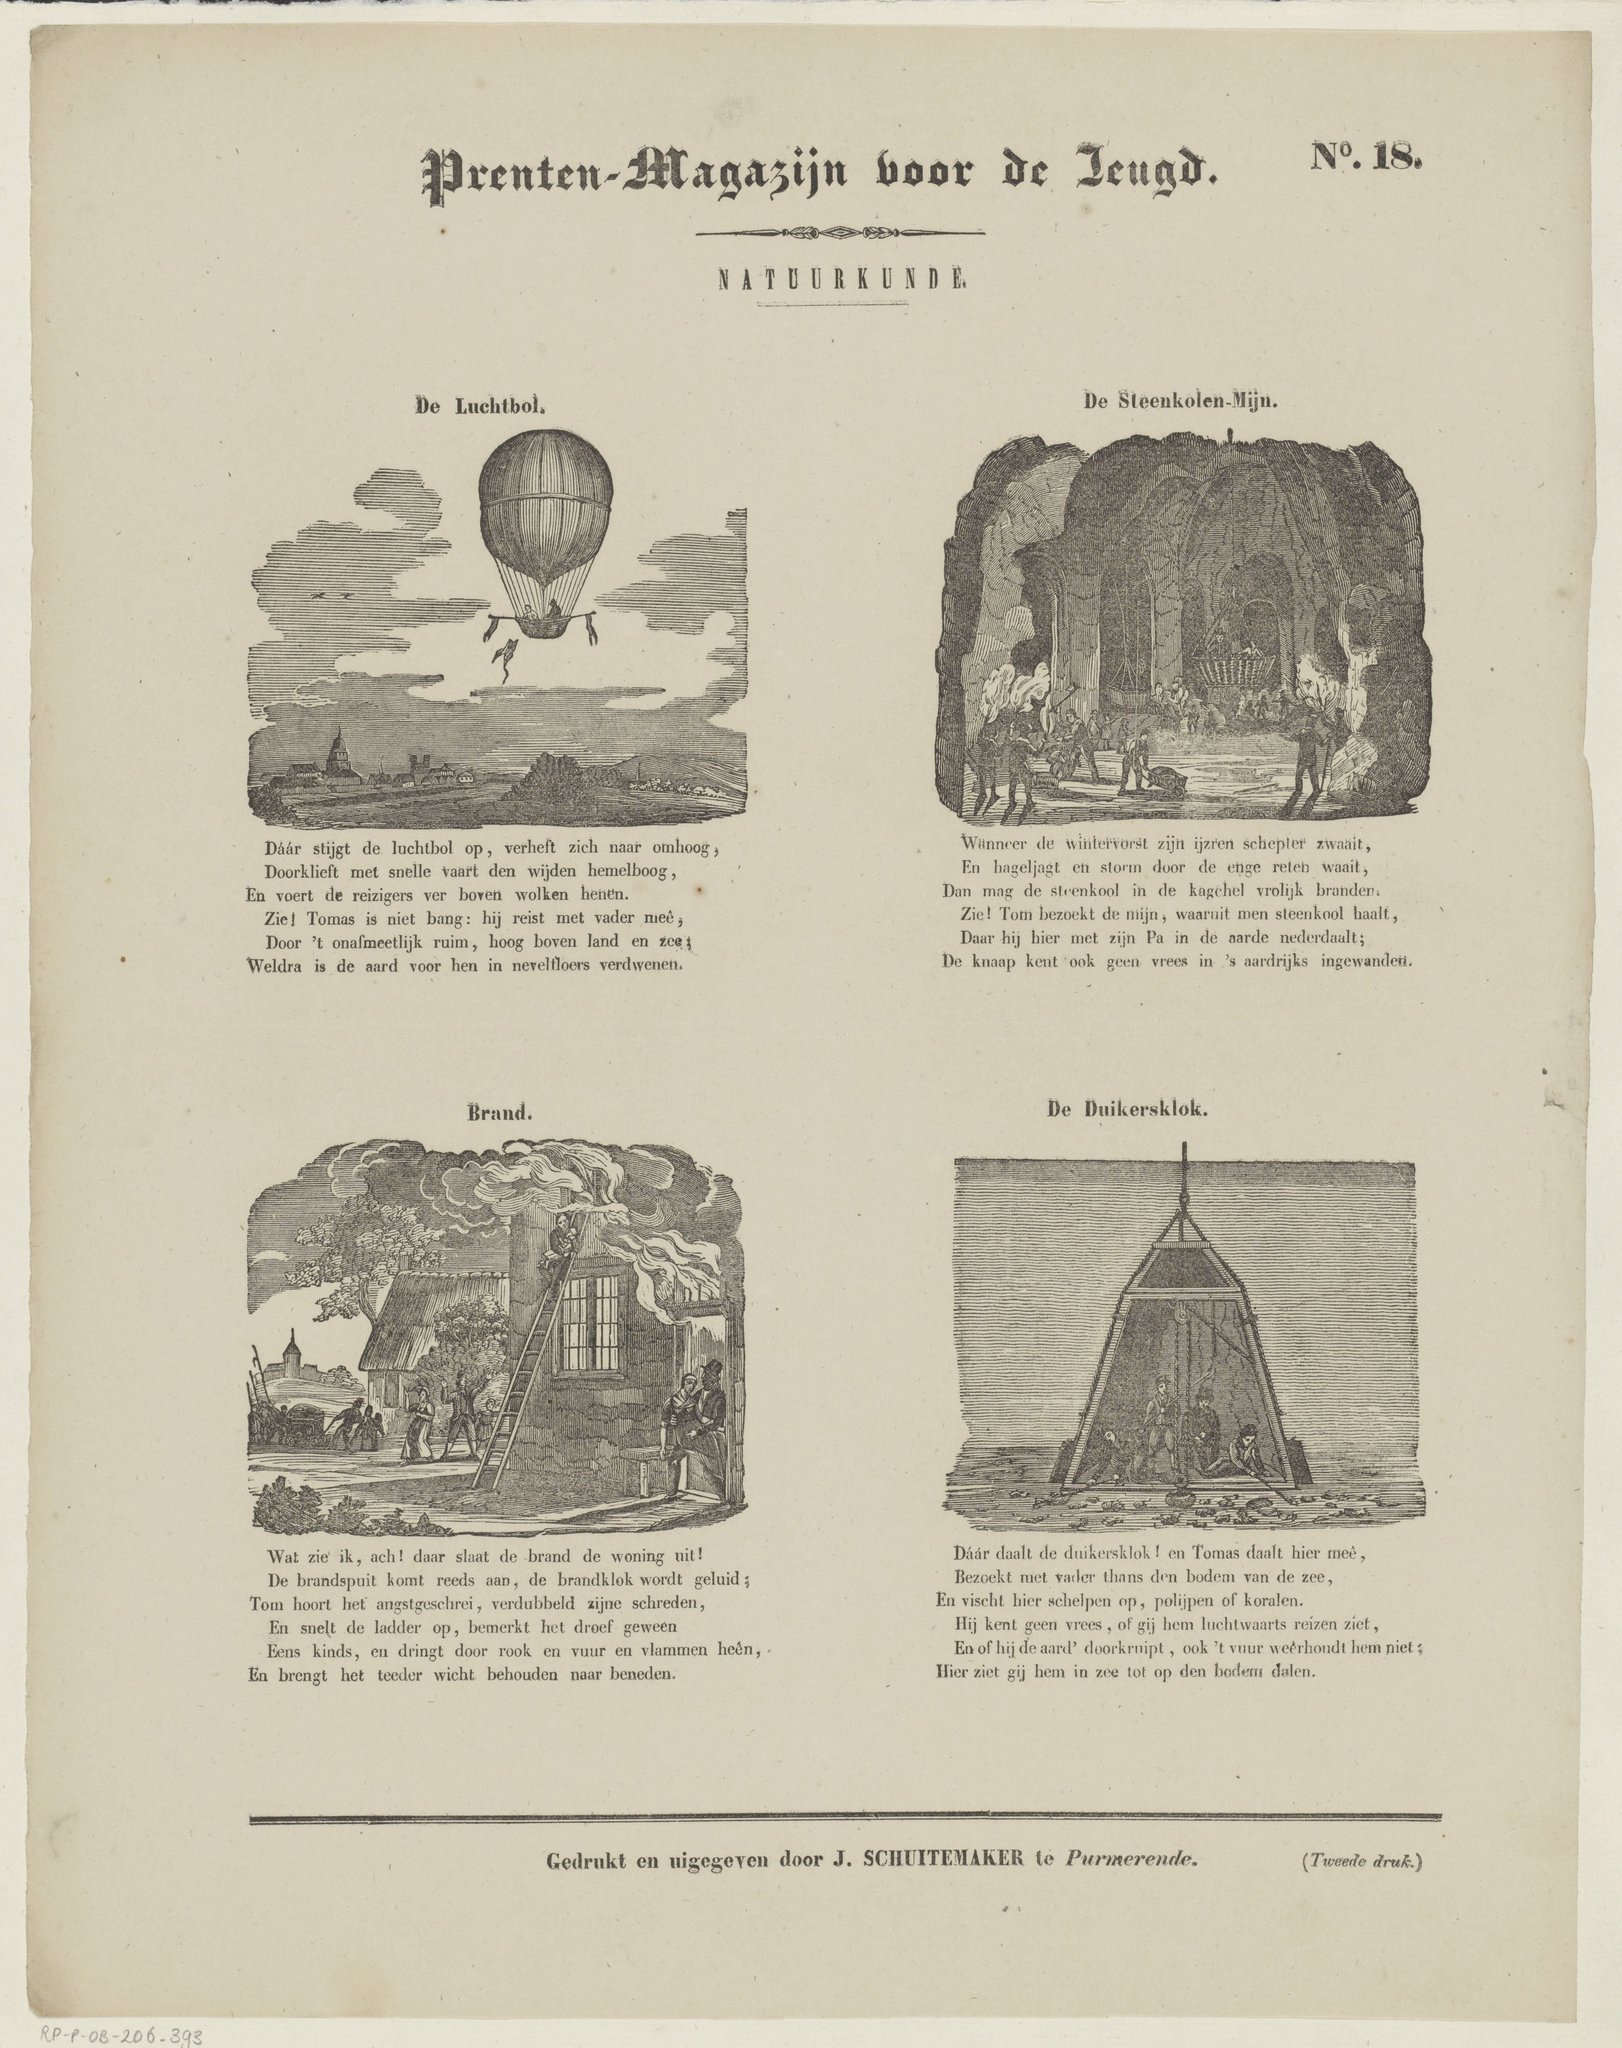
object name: print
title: Natuurkunde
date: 1842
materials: paper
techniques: letterpress printing, engraving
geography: netherlands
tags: on fire, ablaze, (flying a) gas balloon, balloon flight (sport), diving-bell, bathysphere, mine (+ coal), mine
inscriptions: collector's mark: Lugt 2760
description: Blad met 4 voorstellingen van natuurkundige zaken: een luchtballon, een steenkolenmijn, brand en een duikerklok. Boven elke voorstelling een titel en onder elke voorstelling een zesregelig vers. Genummerd rechtsboven: No. 18